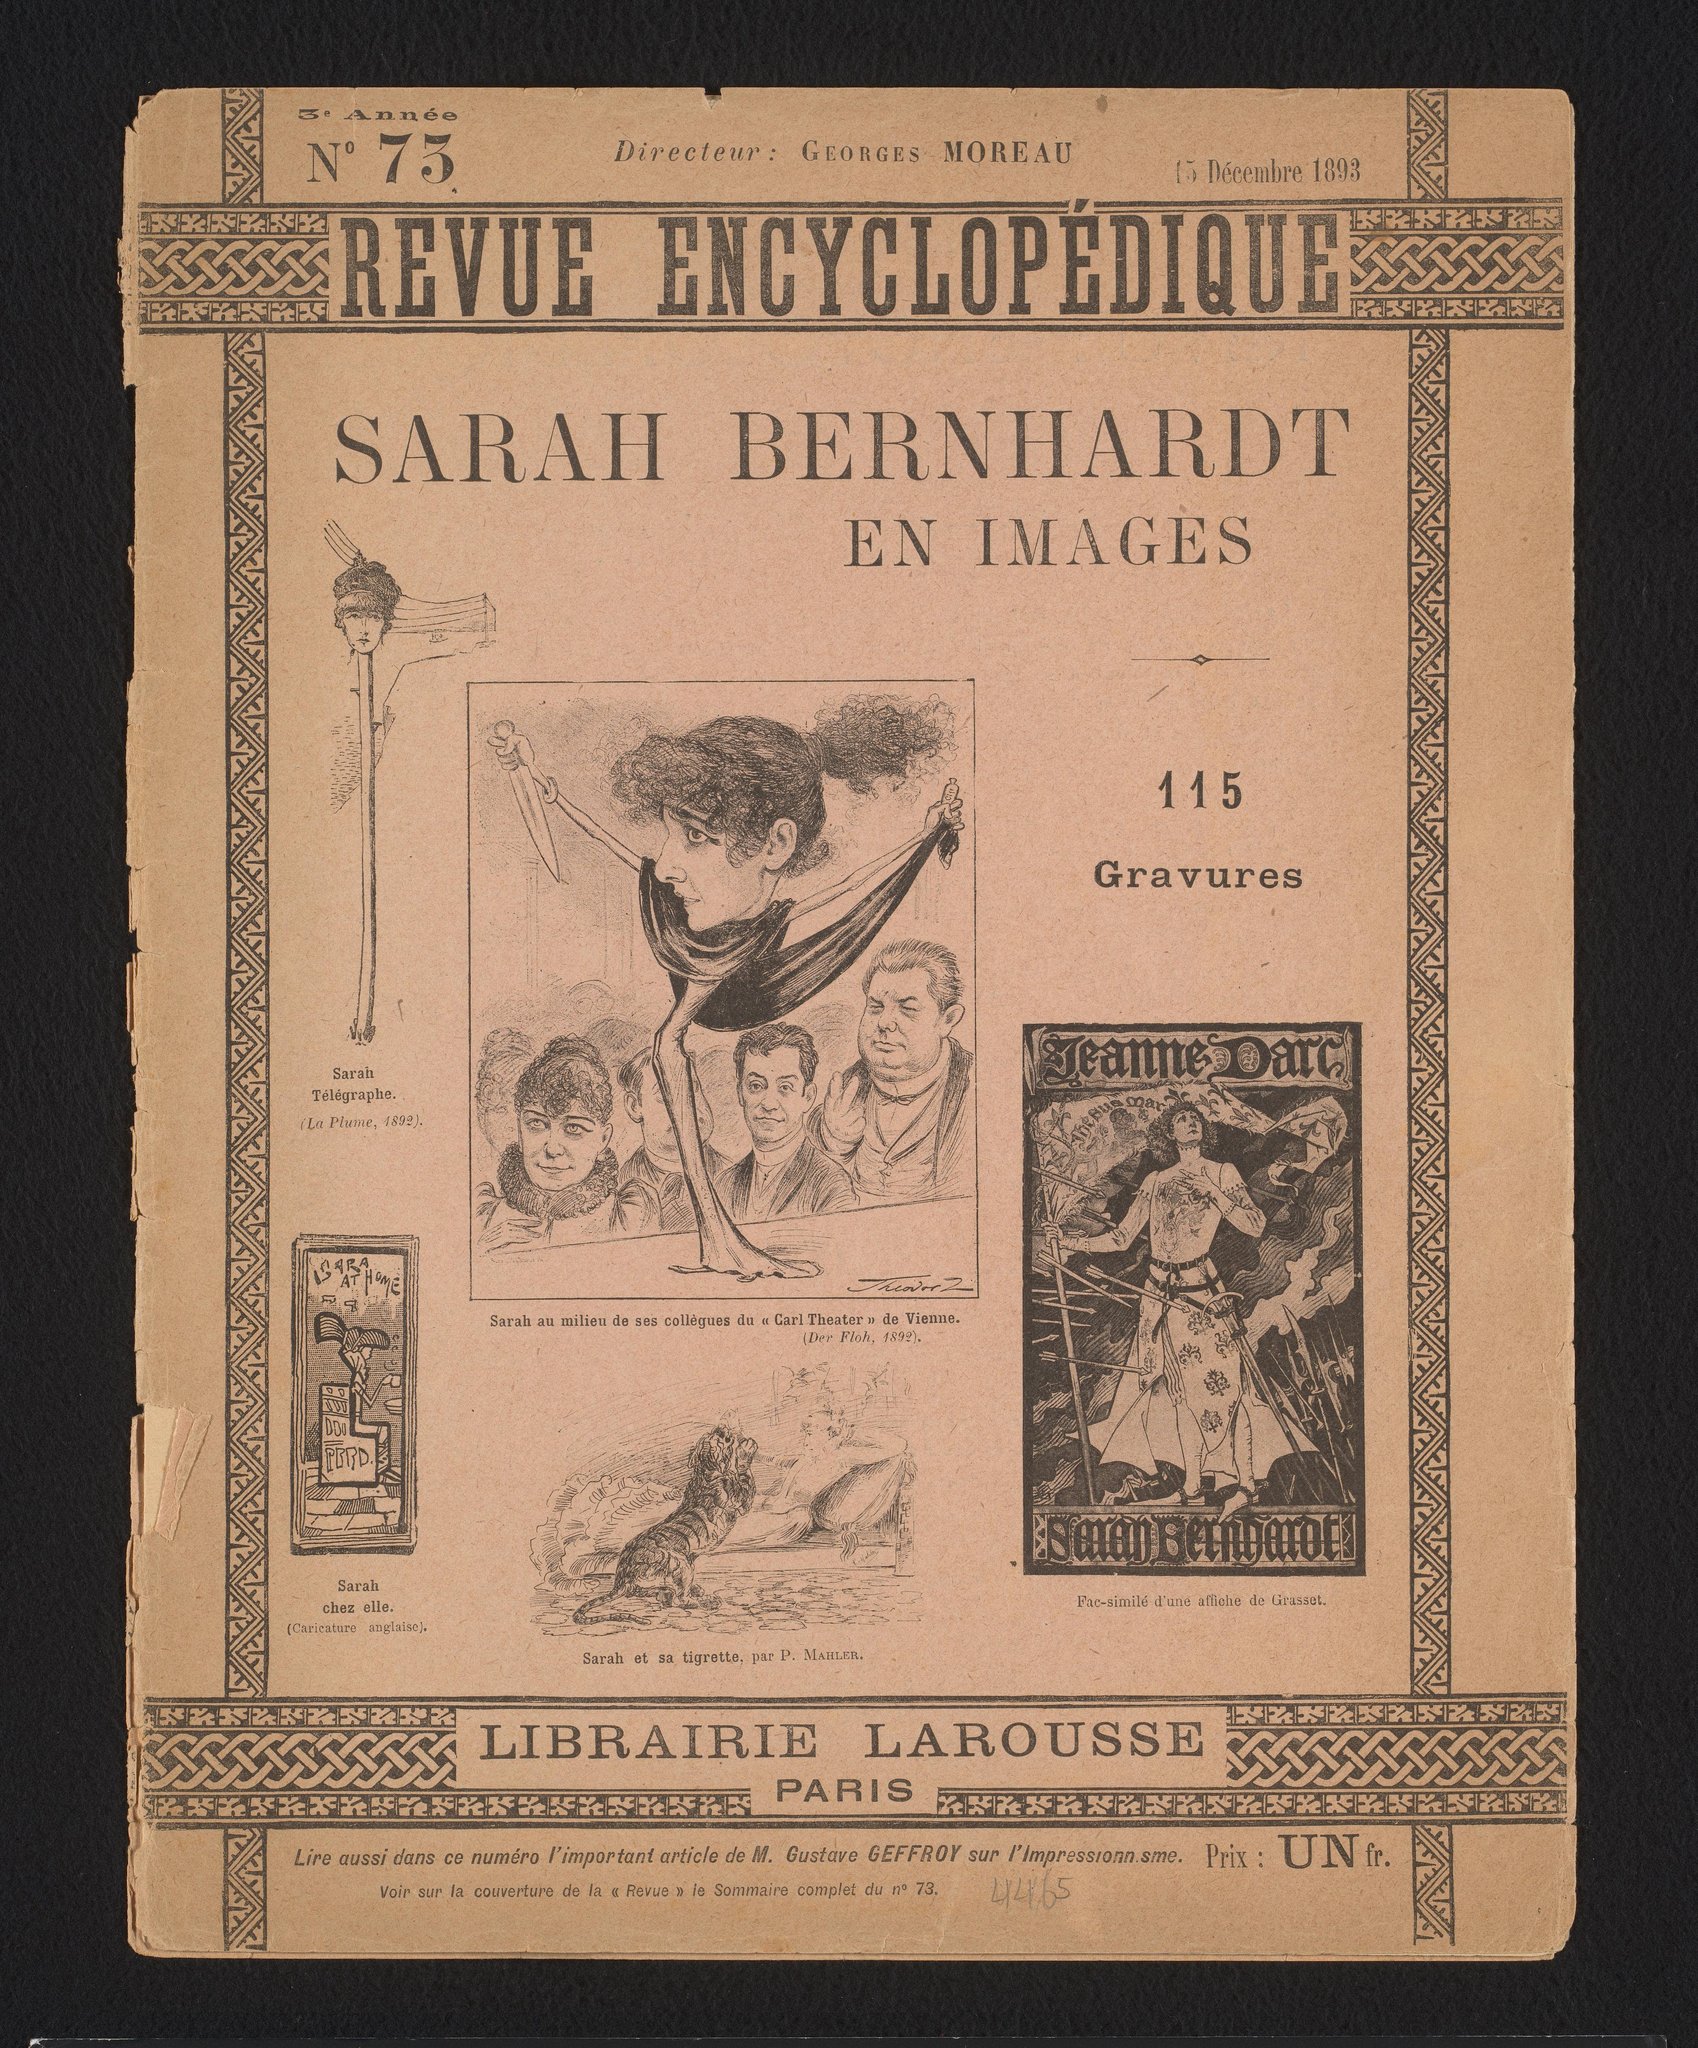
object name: magazine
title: Revue encyclopédique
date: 1893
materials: paper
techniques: printing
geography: paris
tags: paris, sarah bernhardt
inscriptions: number: ‘3e Année/ No 73.’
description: Tijdschrift met 32 reproducties van foto's van Sarah Bernhardt door diverse fotografen.